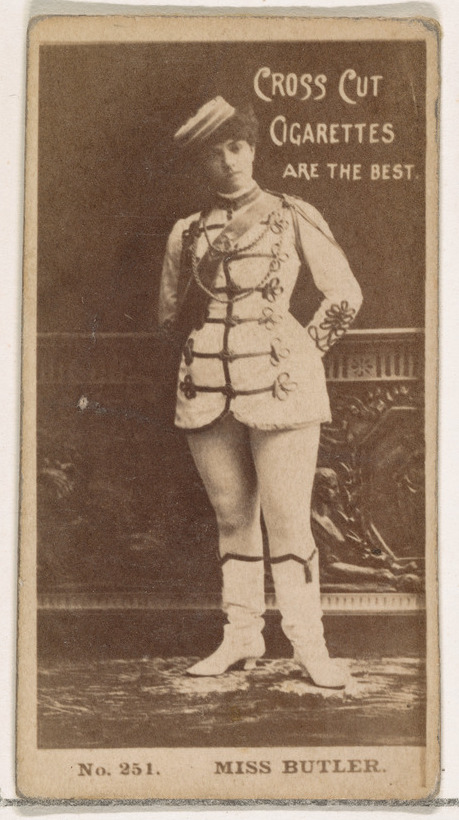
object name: print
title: Card Number 251, Miss Butler, from the Actors and Actresses series (N145-2) issued by Duke Sons & Co. to promote Cross Cut Cigarettes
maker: w. duke, sons & co.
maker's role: publisher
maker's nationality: american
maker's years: 1870-1920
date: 1880-1889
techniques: albumen silver print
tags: portraits,women,actresses